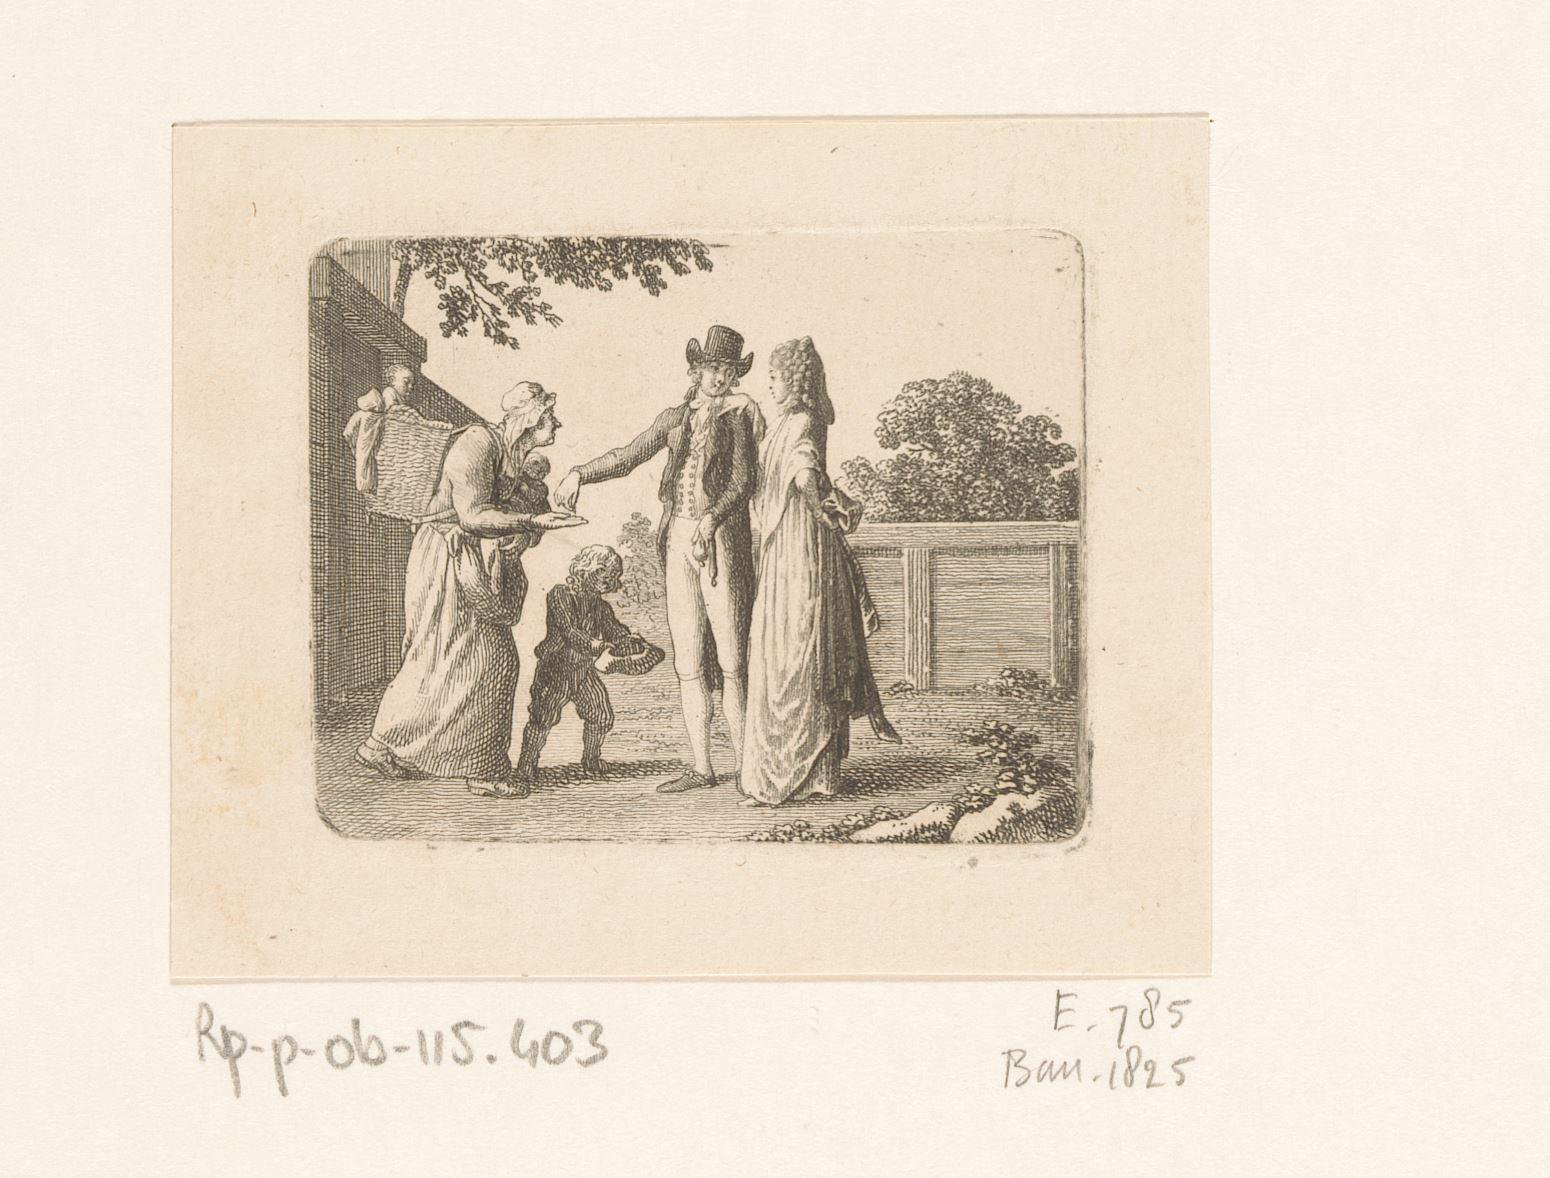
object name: print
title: Emigranten vragen op een aalmoes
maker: daniel nikolaus chodowiecki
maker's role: draughtsman, print maker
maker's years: 1726-1801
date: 1795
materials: paper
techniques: etching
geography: berlin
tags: giving alms or other charity, e.g.: handing out food, emigration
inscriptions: collector's mark: Lugt 2228